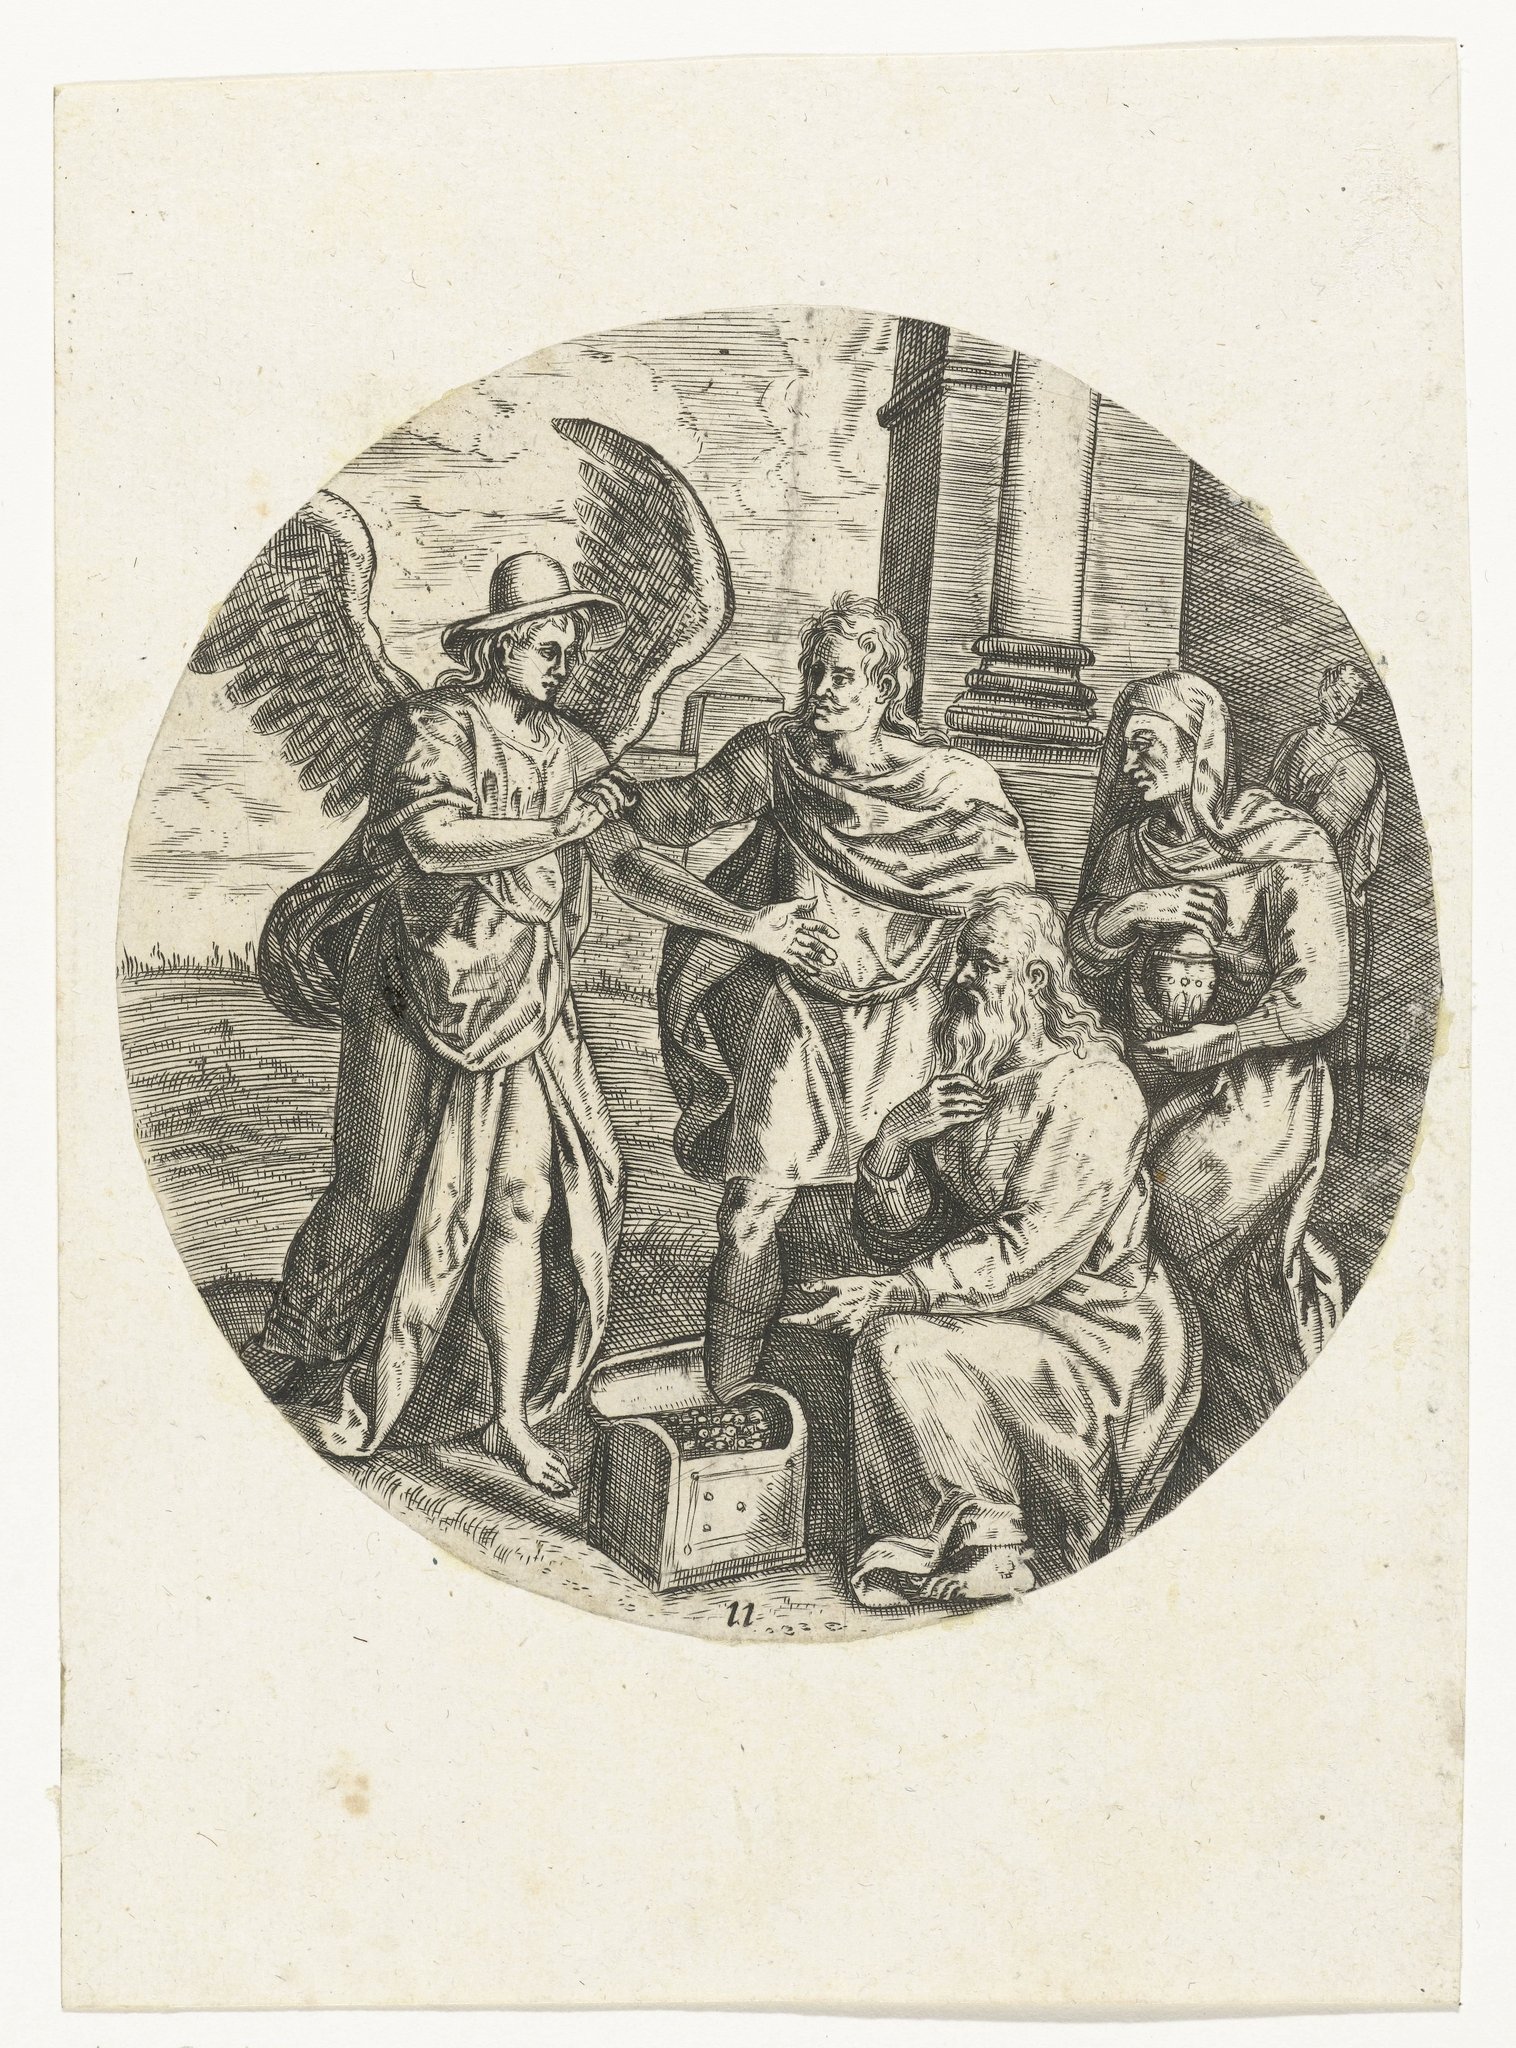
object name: print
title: Verhaal van Tobias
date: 1570-1580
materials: paper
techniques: engraving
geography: netherlands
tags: tobias and his father offer gifts to the angel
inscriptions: collector's mark: Lugt 847a, collector's mark: Lugt 919 bis, collector's mark: Lugt 2760, collector's mark: Lugt 2228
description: Tobit zit geknield voor een kist met geldstukken en biedt deze aan aan de engel. Tobias en Anna staan achter hem.